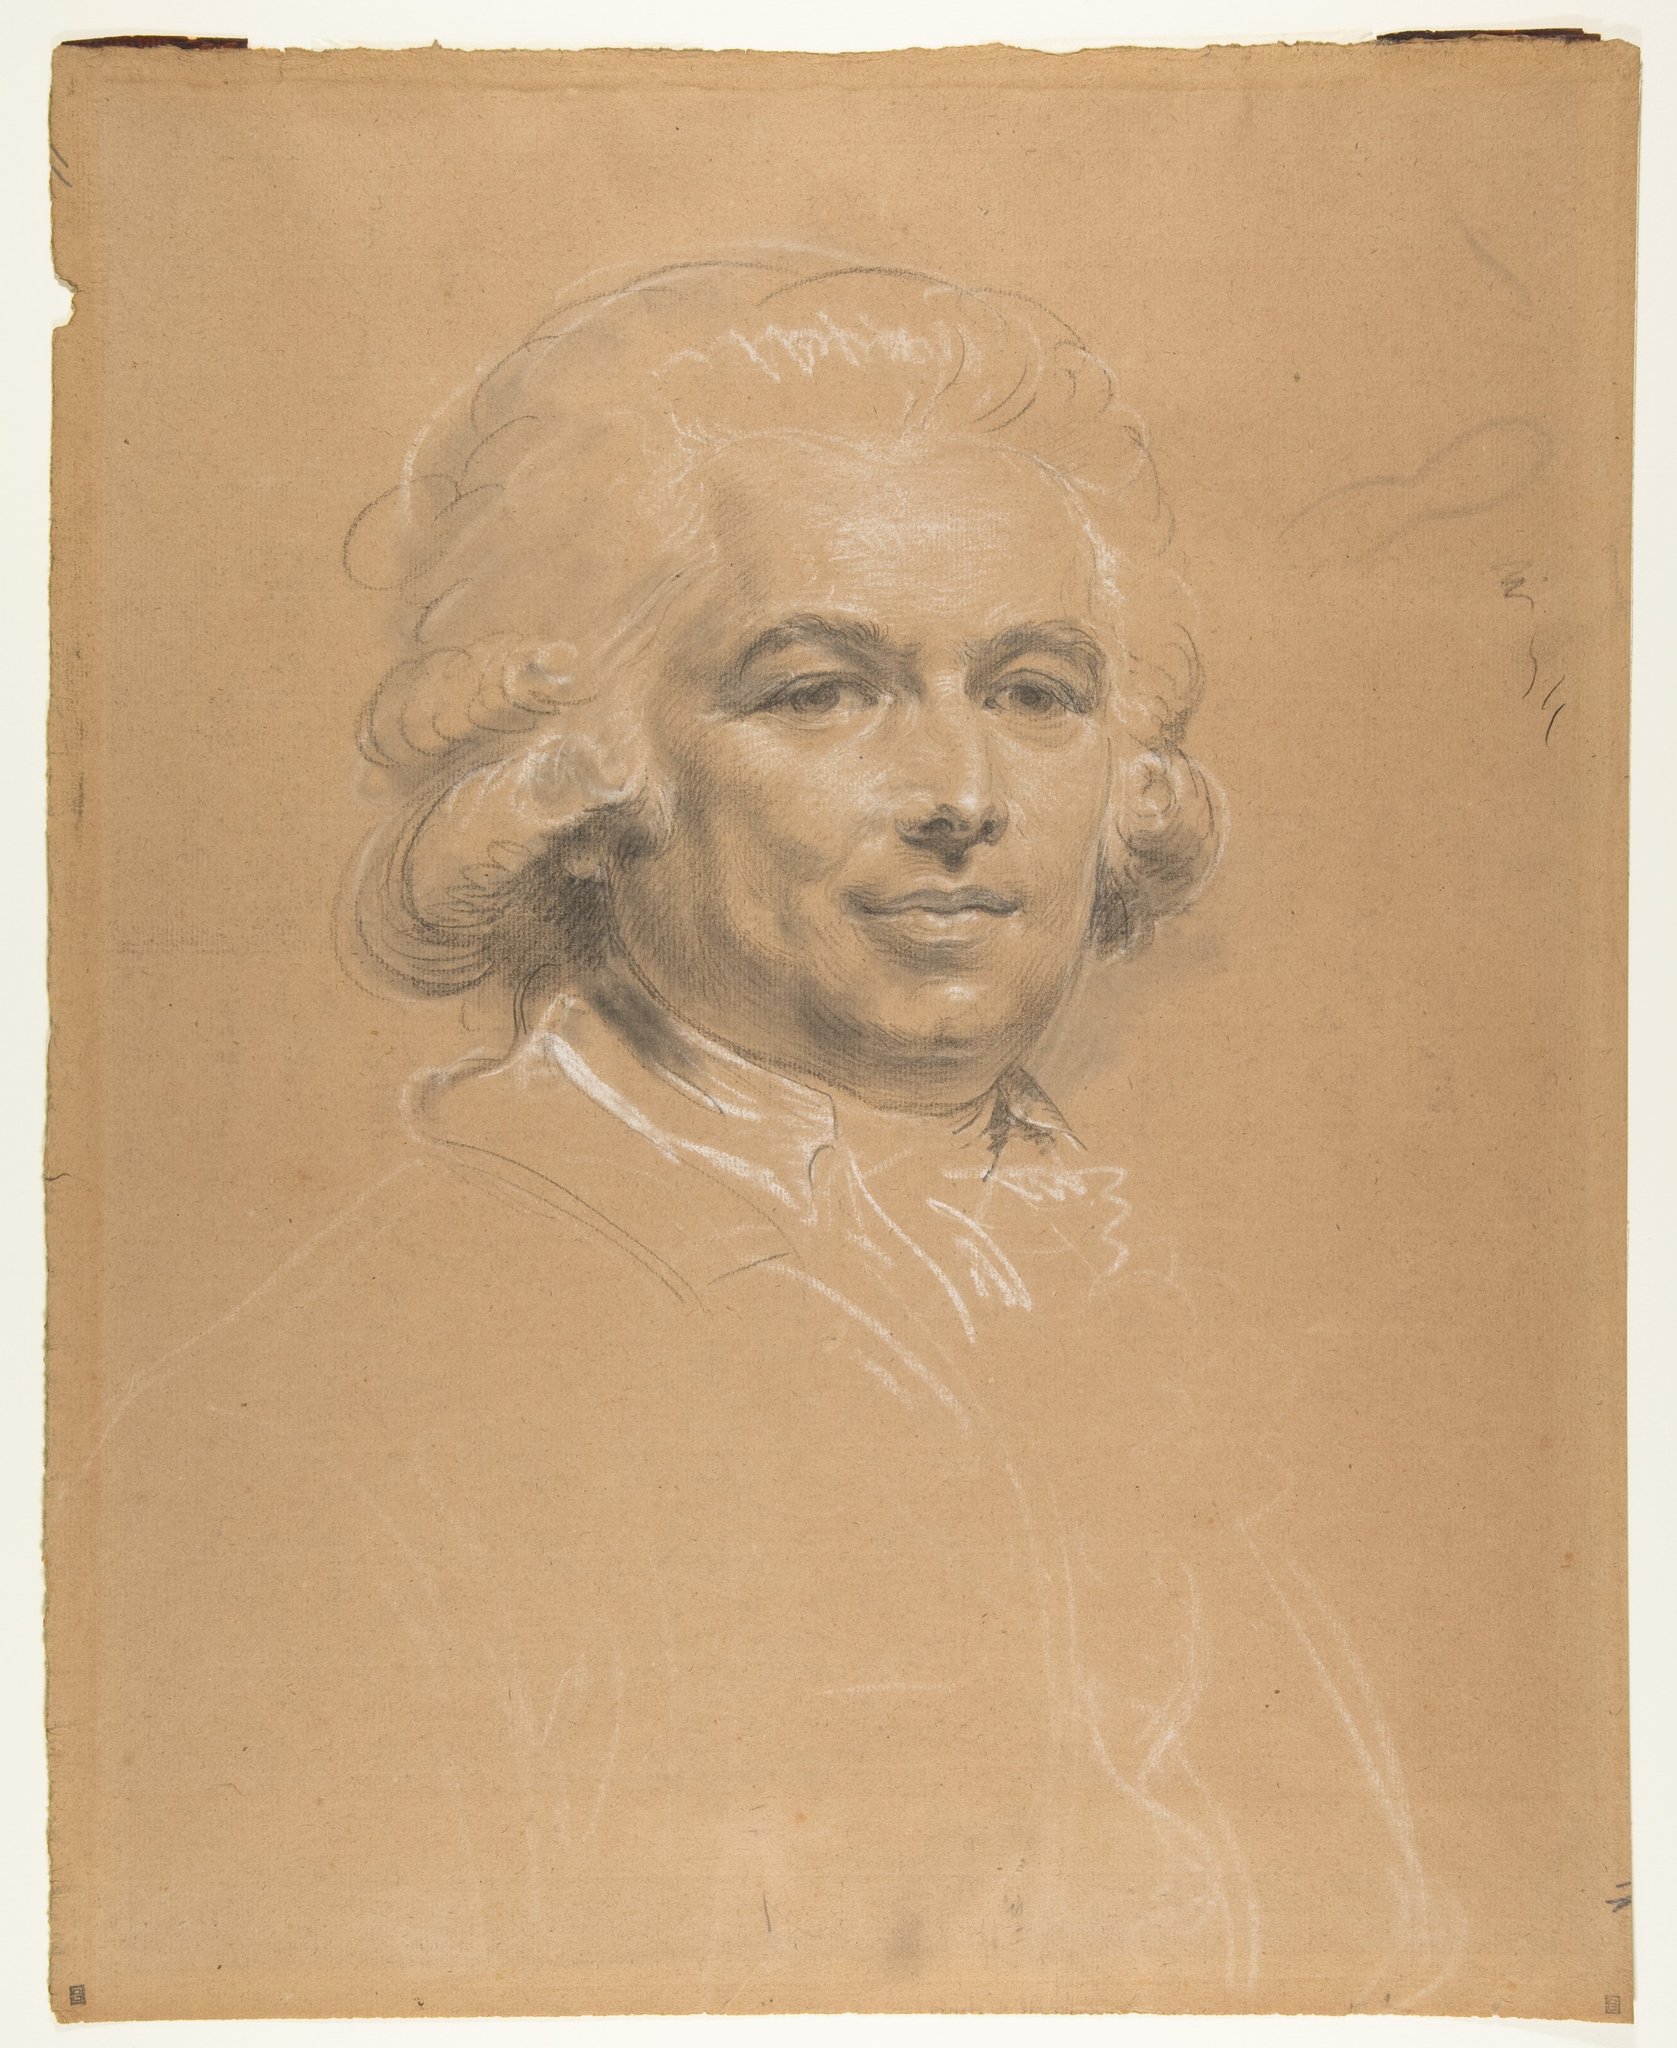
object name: drawing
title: Head of a Man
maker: claude jean-baptiste hoin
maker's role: artist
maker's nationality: french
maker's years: 1750-1817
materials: chalk, charcoal, paper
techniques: heightening, stumping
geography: france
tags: heads,men